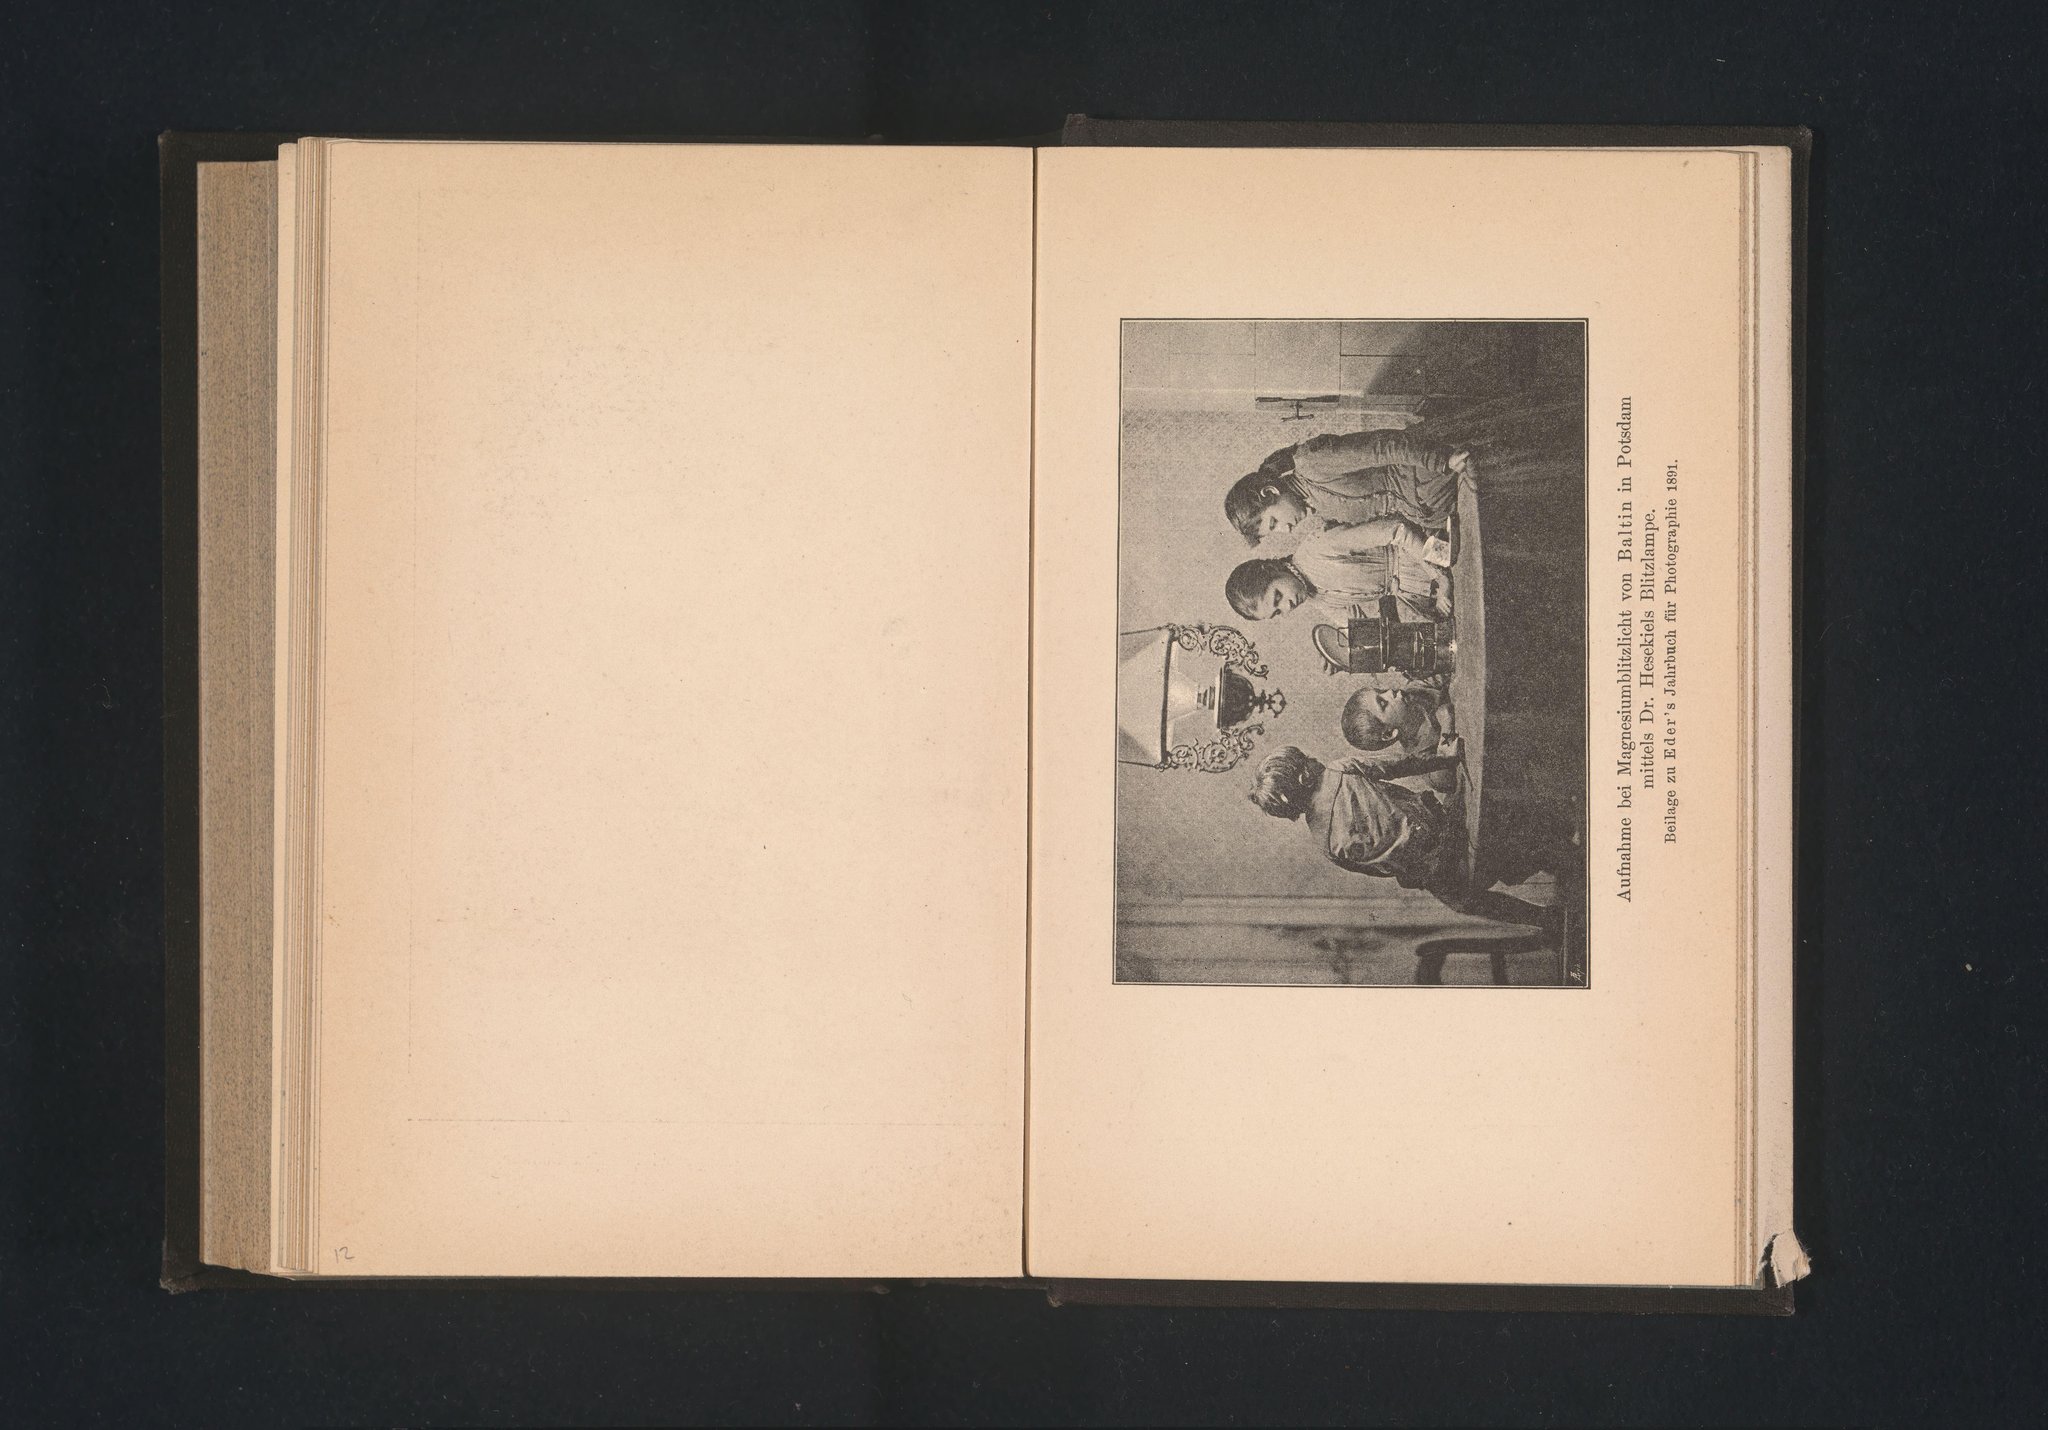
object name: photomechanical print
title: Groep onbekende kinderen aan de keukentafel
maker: Anonymous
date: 1886-1891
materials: paper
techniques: autotype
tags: kitchen, potatoes, anonymous historical persons portrayed in a group, in a group-portrait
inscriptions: monogram: ‘AC’, inscription: ‘Aufnahme bei Magnesiumblitzlicht von Baltin in Potsdam mittels Dr. Hesekiels Blitzlampe/ Beilage zu Eder's Jahbruch für Photographie 1891’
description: Prent op vierendertigste ongenummerde pagina na pagina 627.